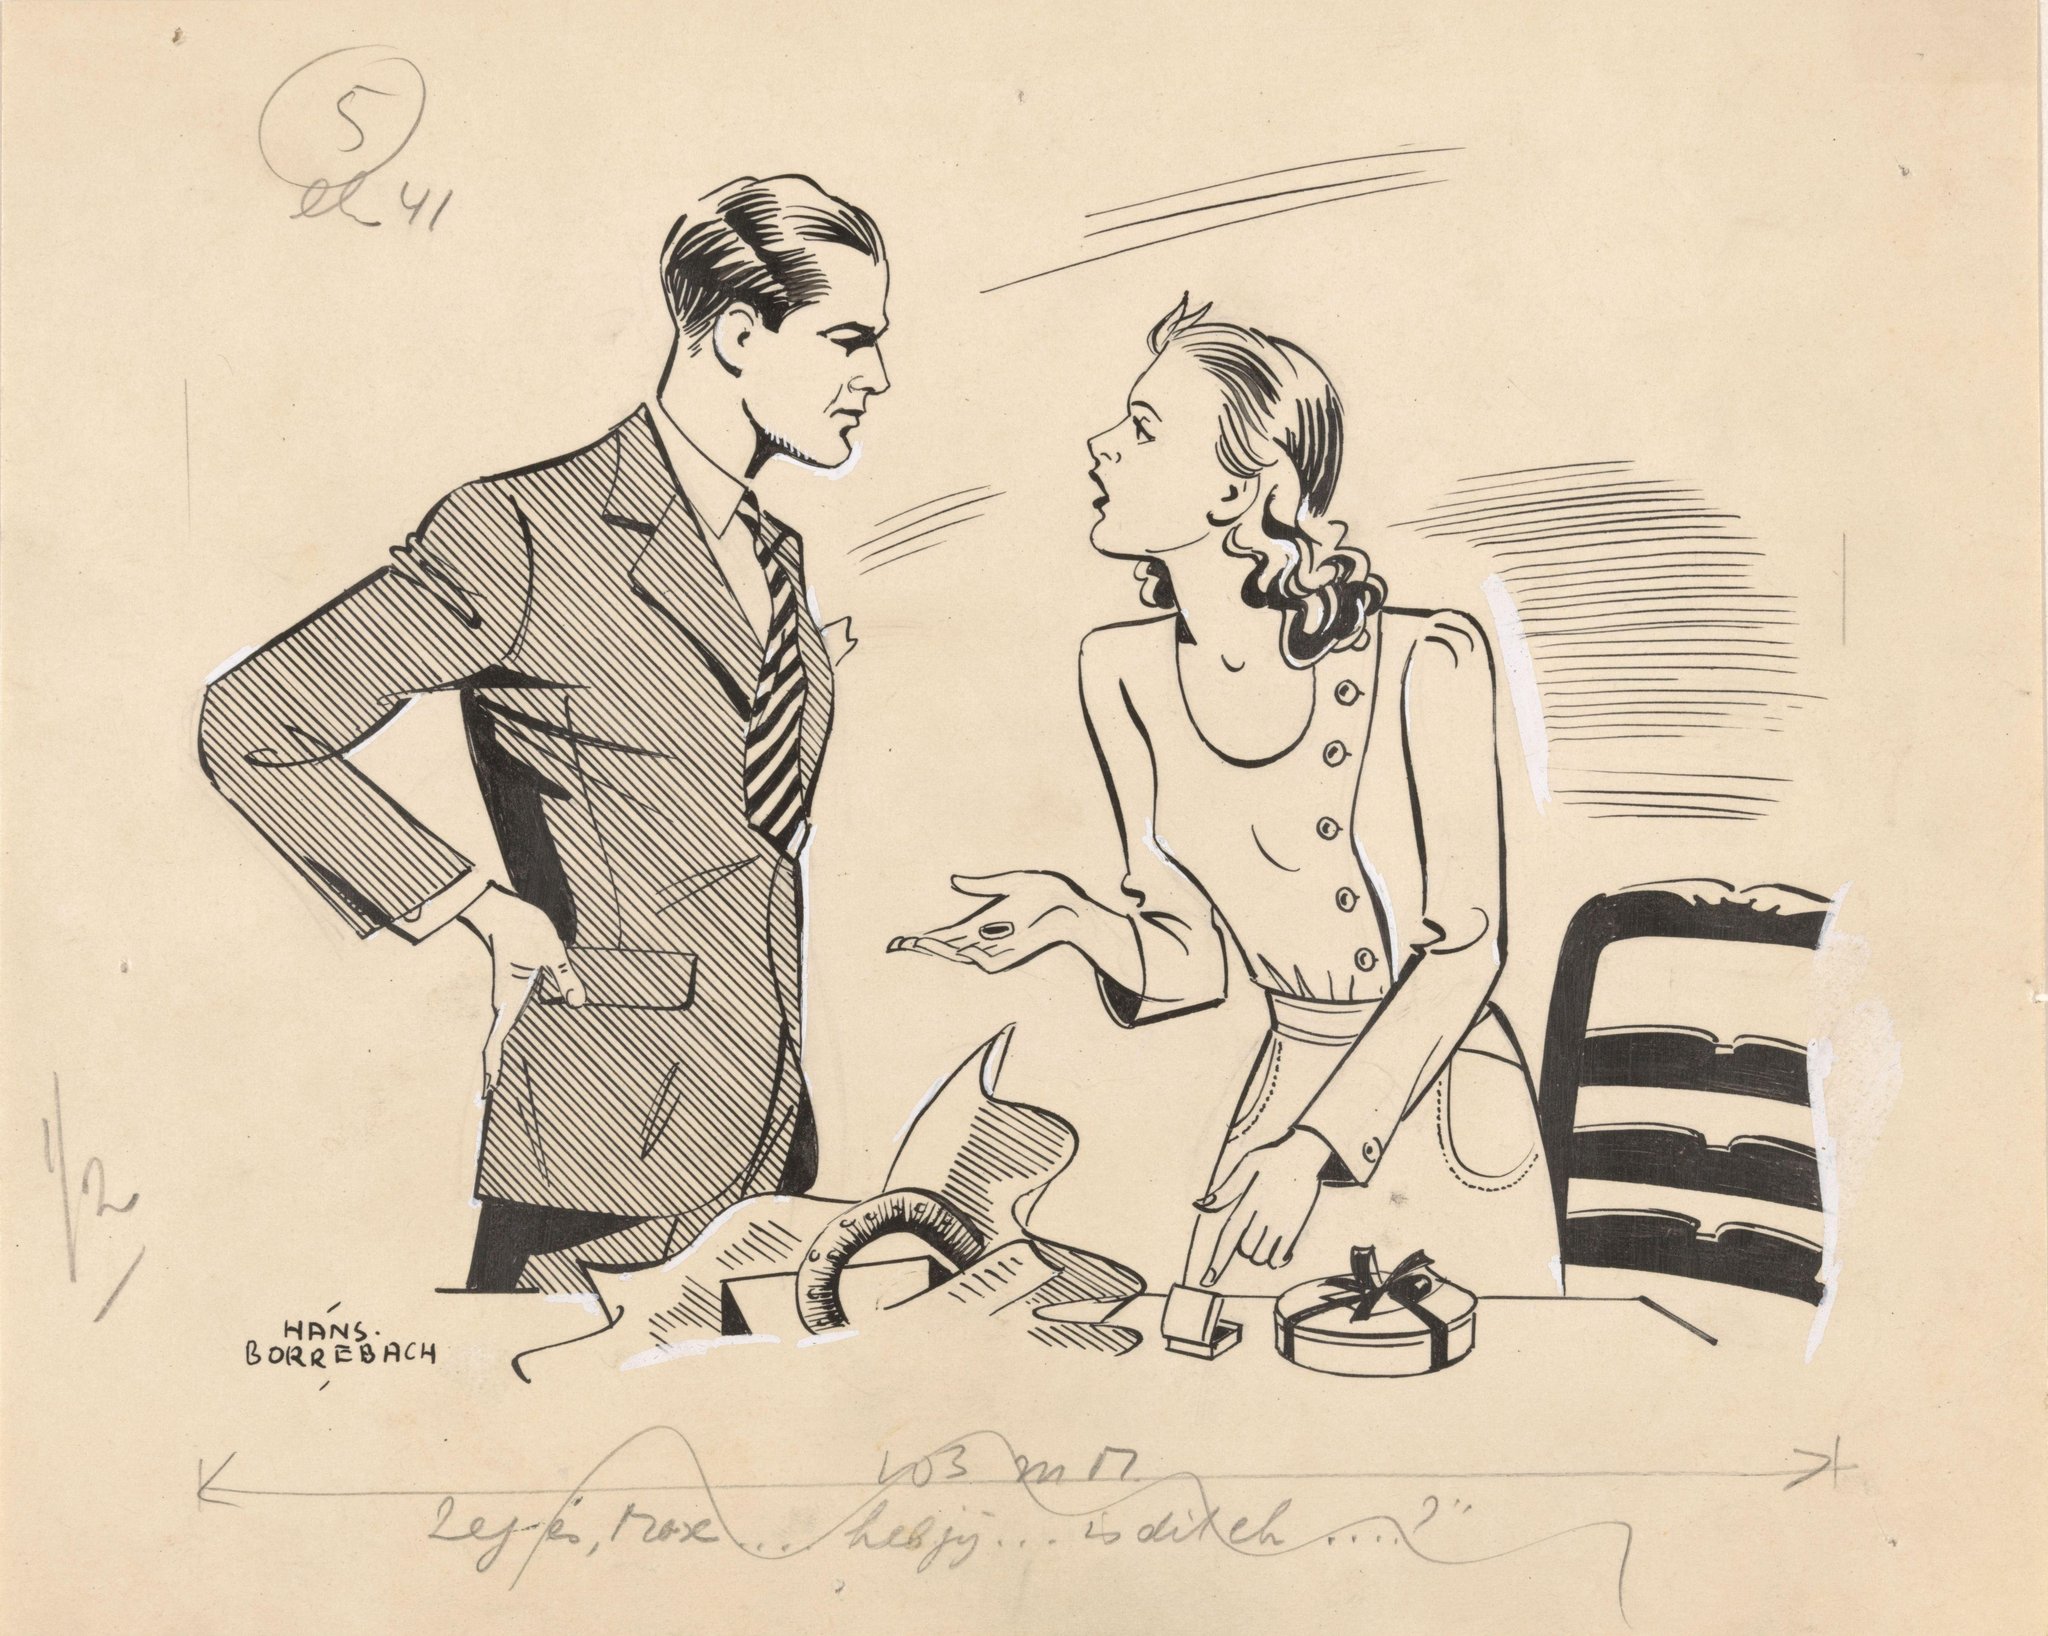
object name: drawing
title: Pepita kijkt vragend naar Max met een ring in haar hand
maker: hans borrebach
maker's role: draughtsman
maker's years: 1903-1991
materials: paint, ink, paper, pencil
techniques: brush, pen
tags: palm of the hand turned up, ring, lovers; courting, flirting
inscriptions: signature: ‘HANS./ BORREBACH’, :, annotation: ‘5/ bz 41/ Zeg es, Max ....heb jij ... is dit eh....?"’, collector's mark: Lugt 2228a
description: Pepita staat naast een jonge man, genaamd Max, bij een tafel. Ze kijkt hem vragend aan en wijst naar een ringdoos die op tafel ligt naast een doos met een strik. In de palm van haar rechterhand ligt een ring.